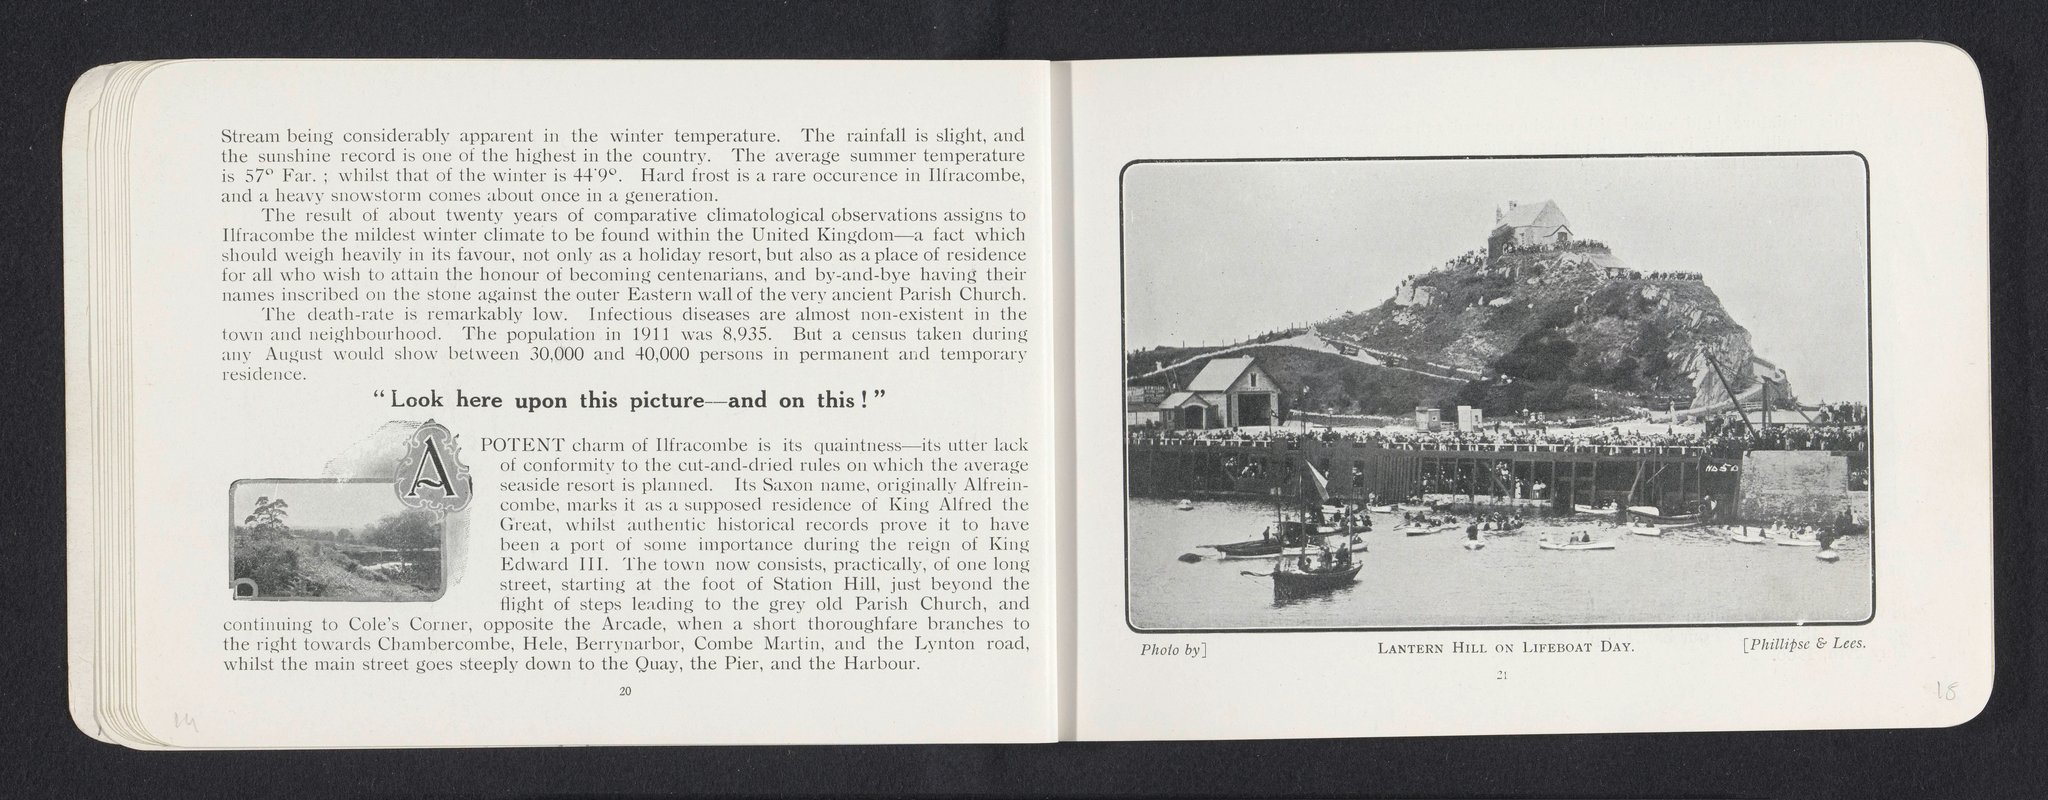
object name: photomechanical print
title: Lantern Hill on Lifeboat Day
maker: Anonymous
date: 1900-1920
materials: paper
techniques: autotype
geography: ilfracombe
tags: cape (coast), rowing-boat, canoe, etc.